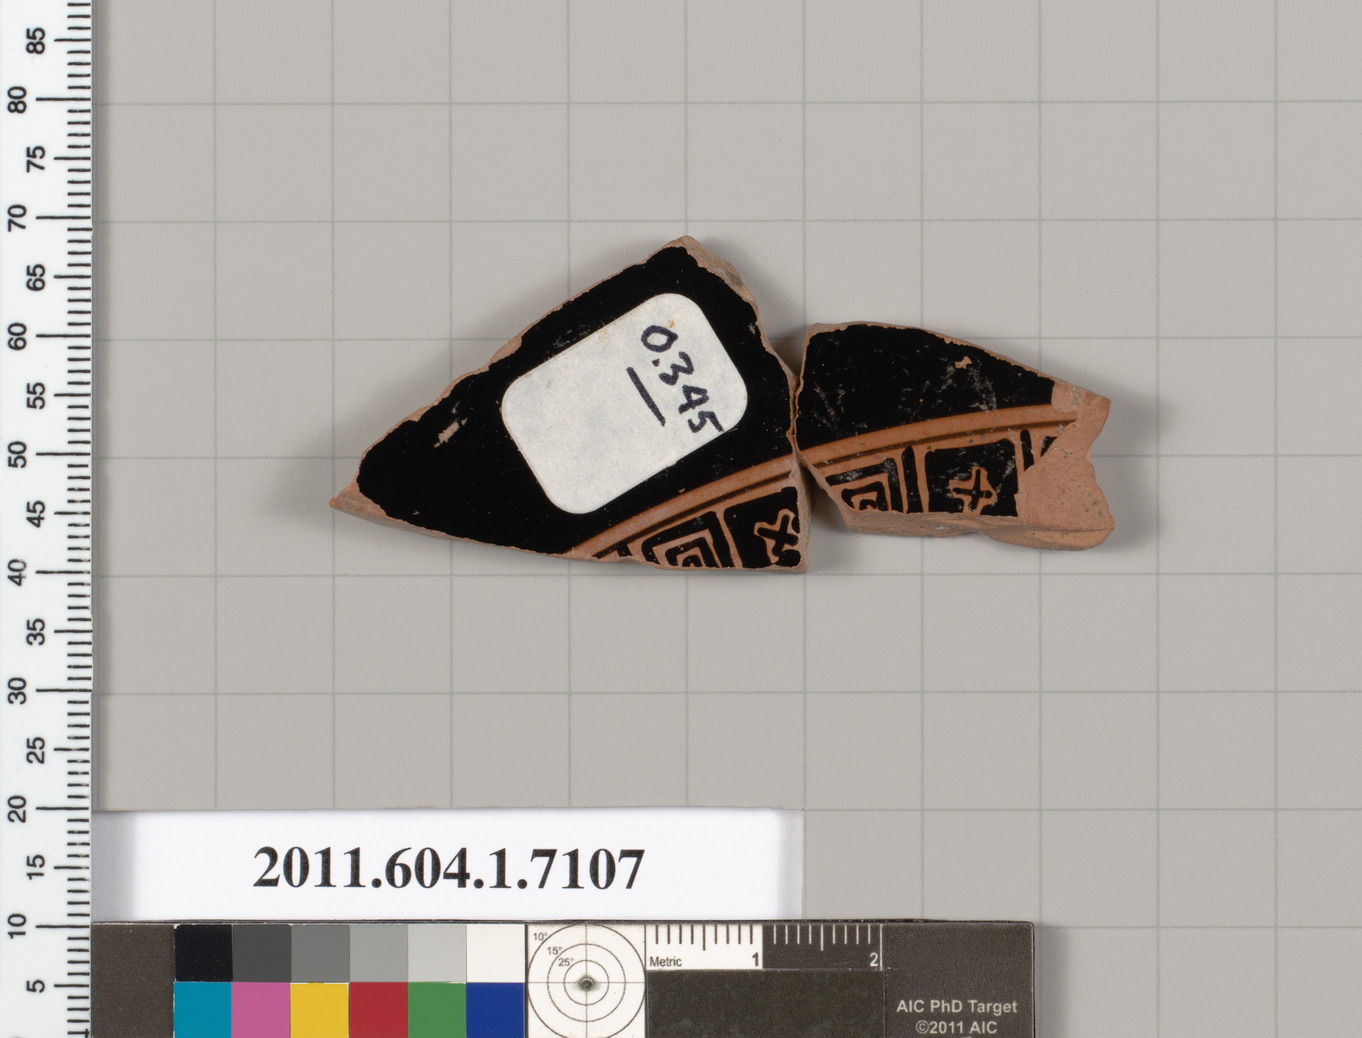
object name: kylix fragment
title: Terracotta fragment of a kylix (drinking cup)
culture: greek, attic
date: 500-480 BCE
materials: terracotta